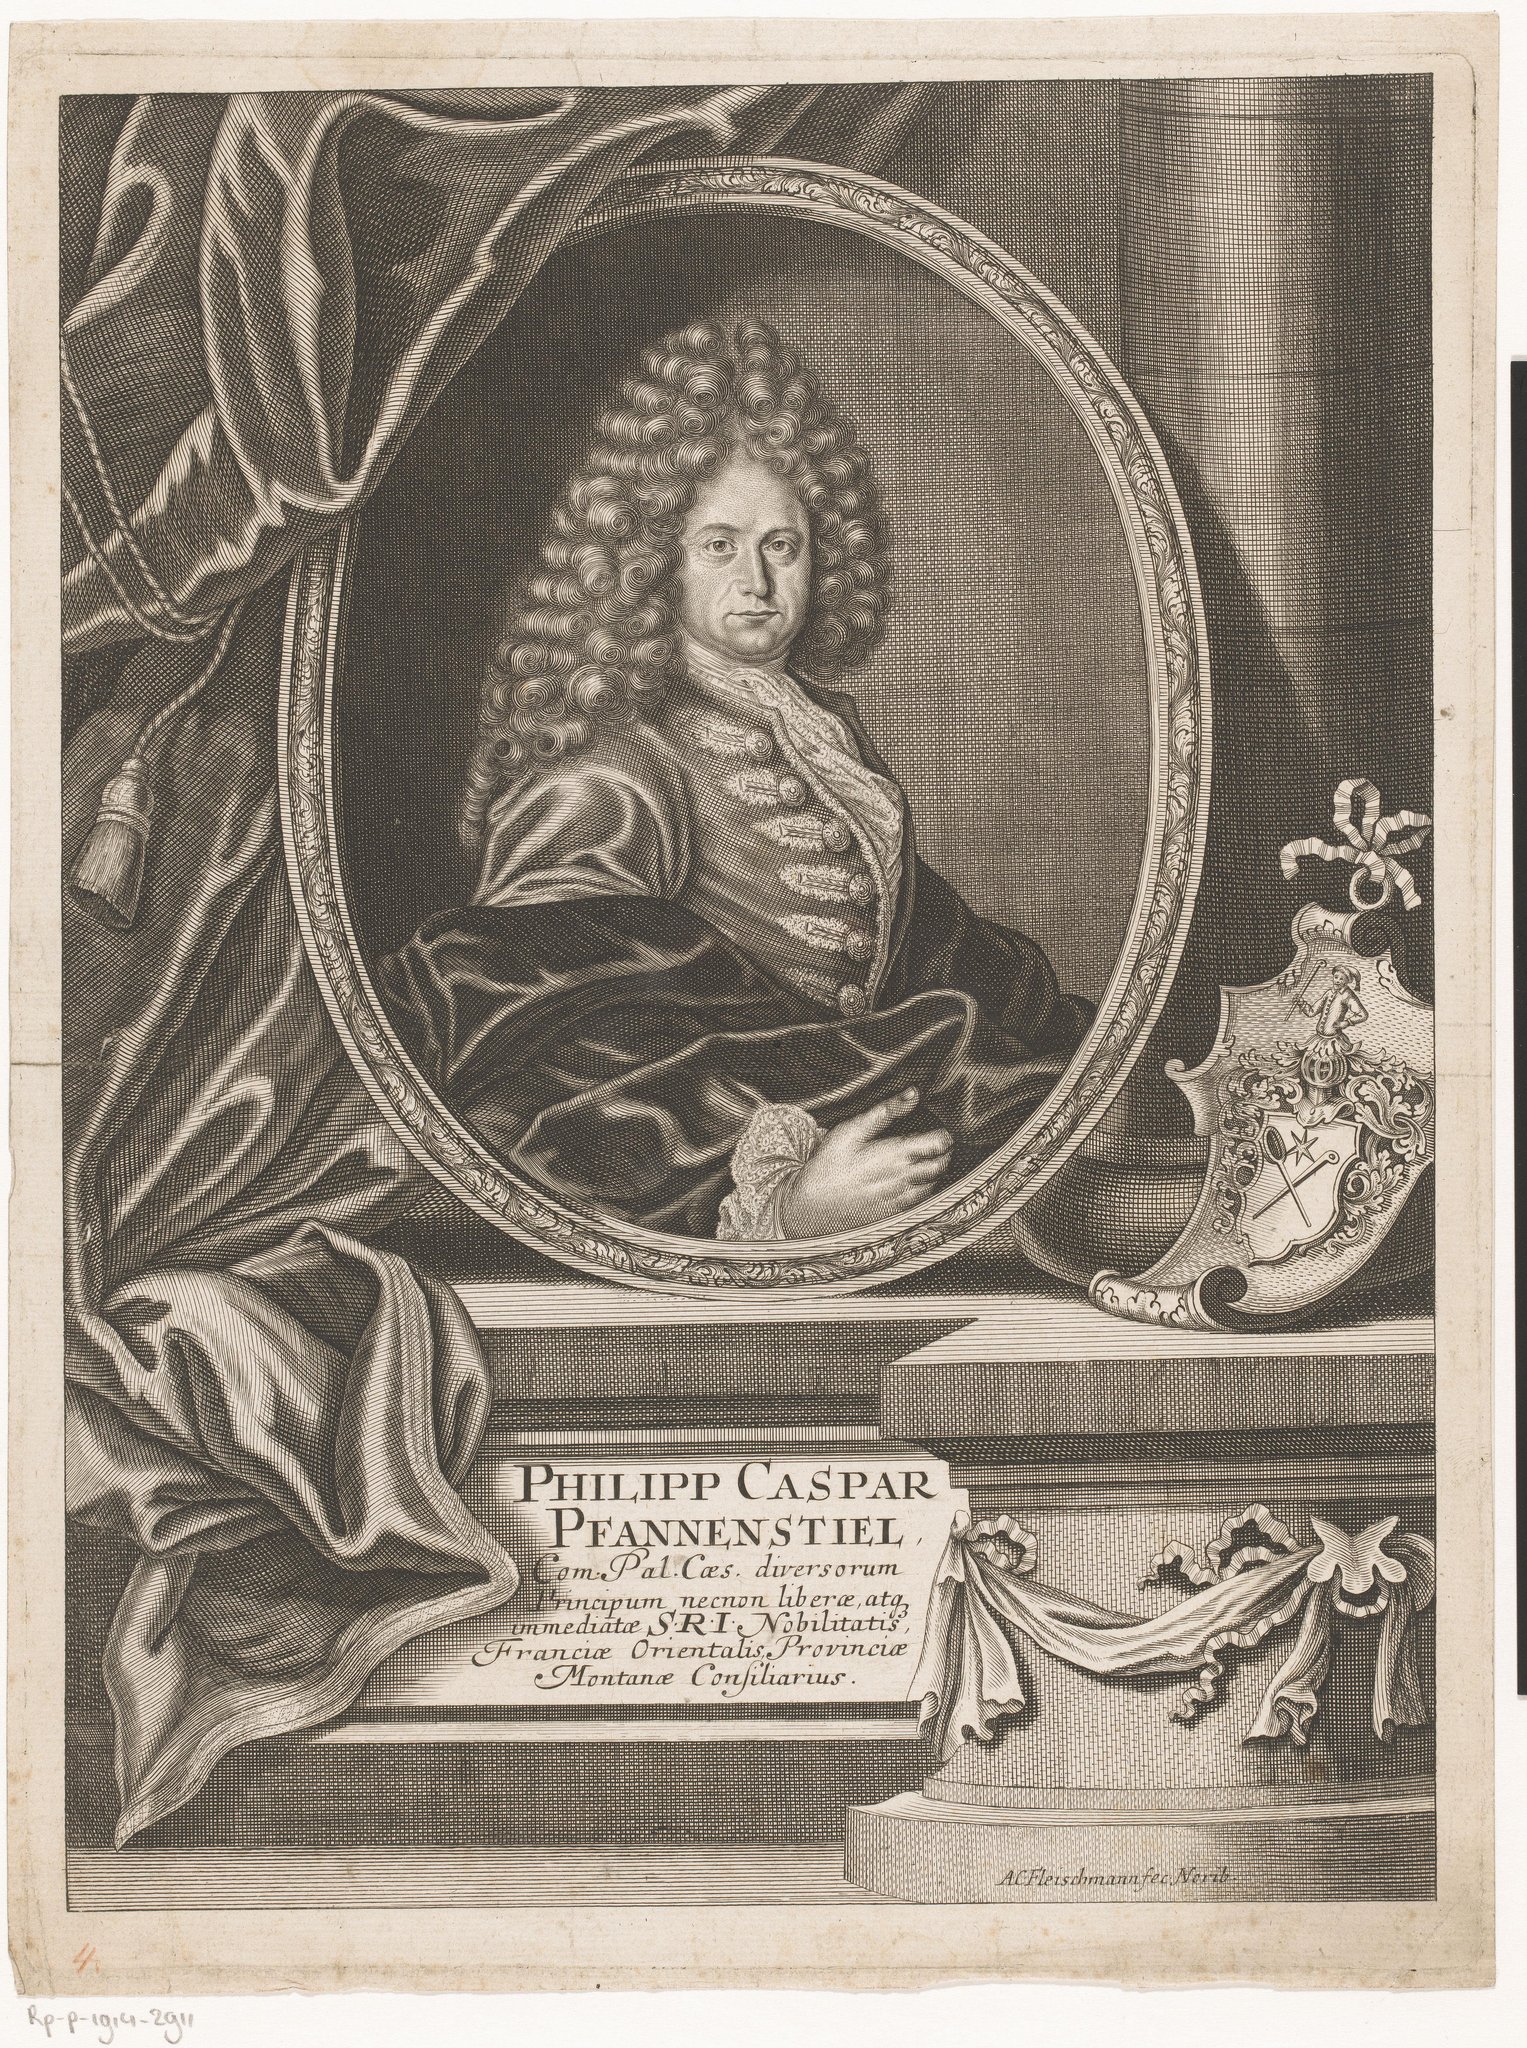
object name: print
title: Portret van Philipp Caspar Pfannenstiel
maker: august christian fleischmann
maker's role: print maker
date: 1704-1732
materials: paper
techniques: engraving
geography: nuremberg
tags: (feigned) picture curtain, ornament ~ medallion, historical persons, armorial bearing, heraldry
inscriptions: collector's mark: Lugt 2228